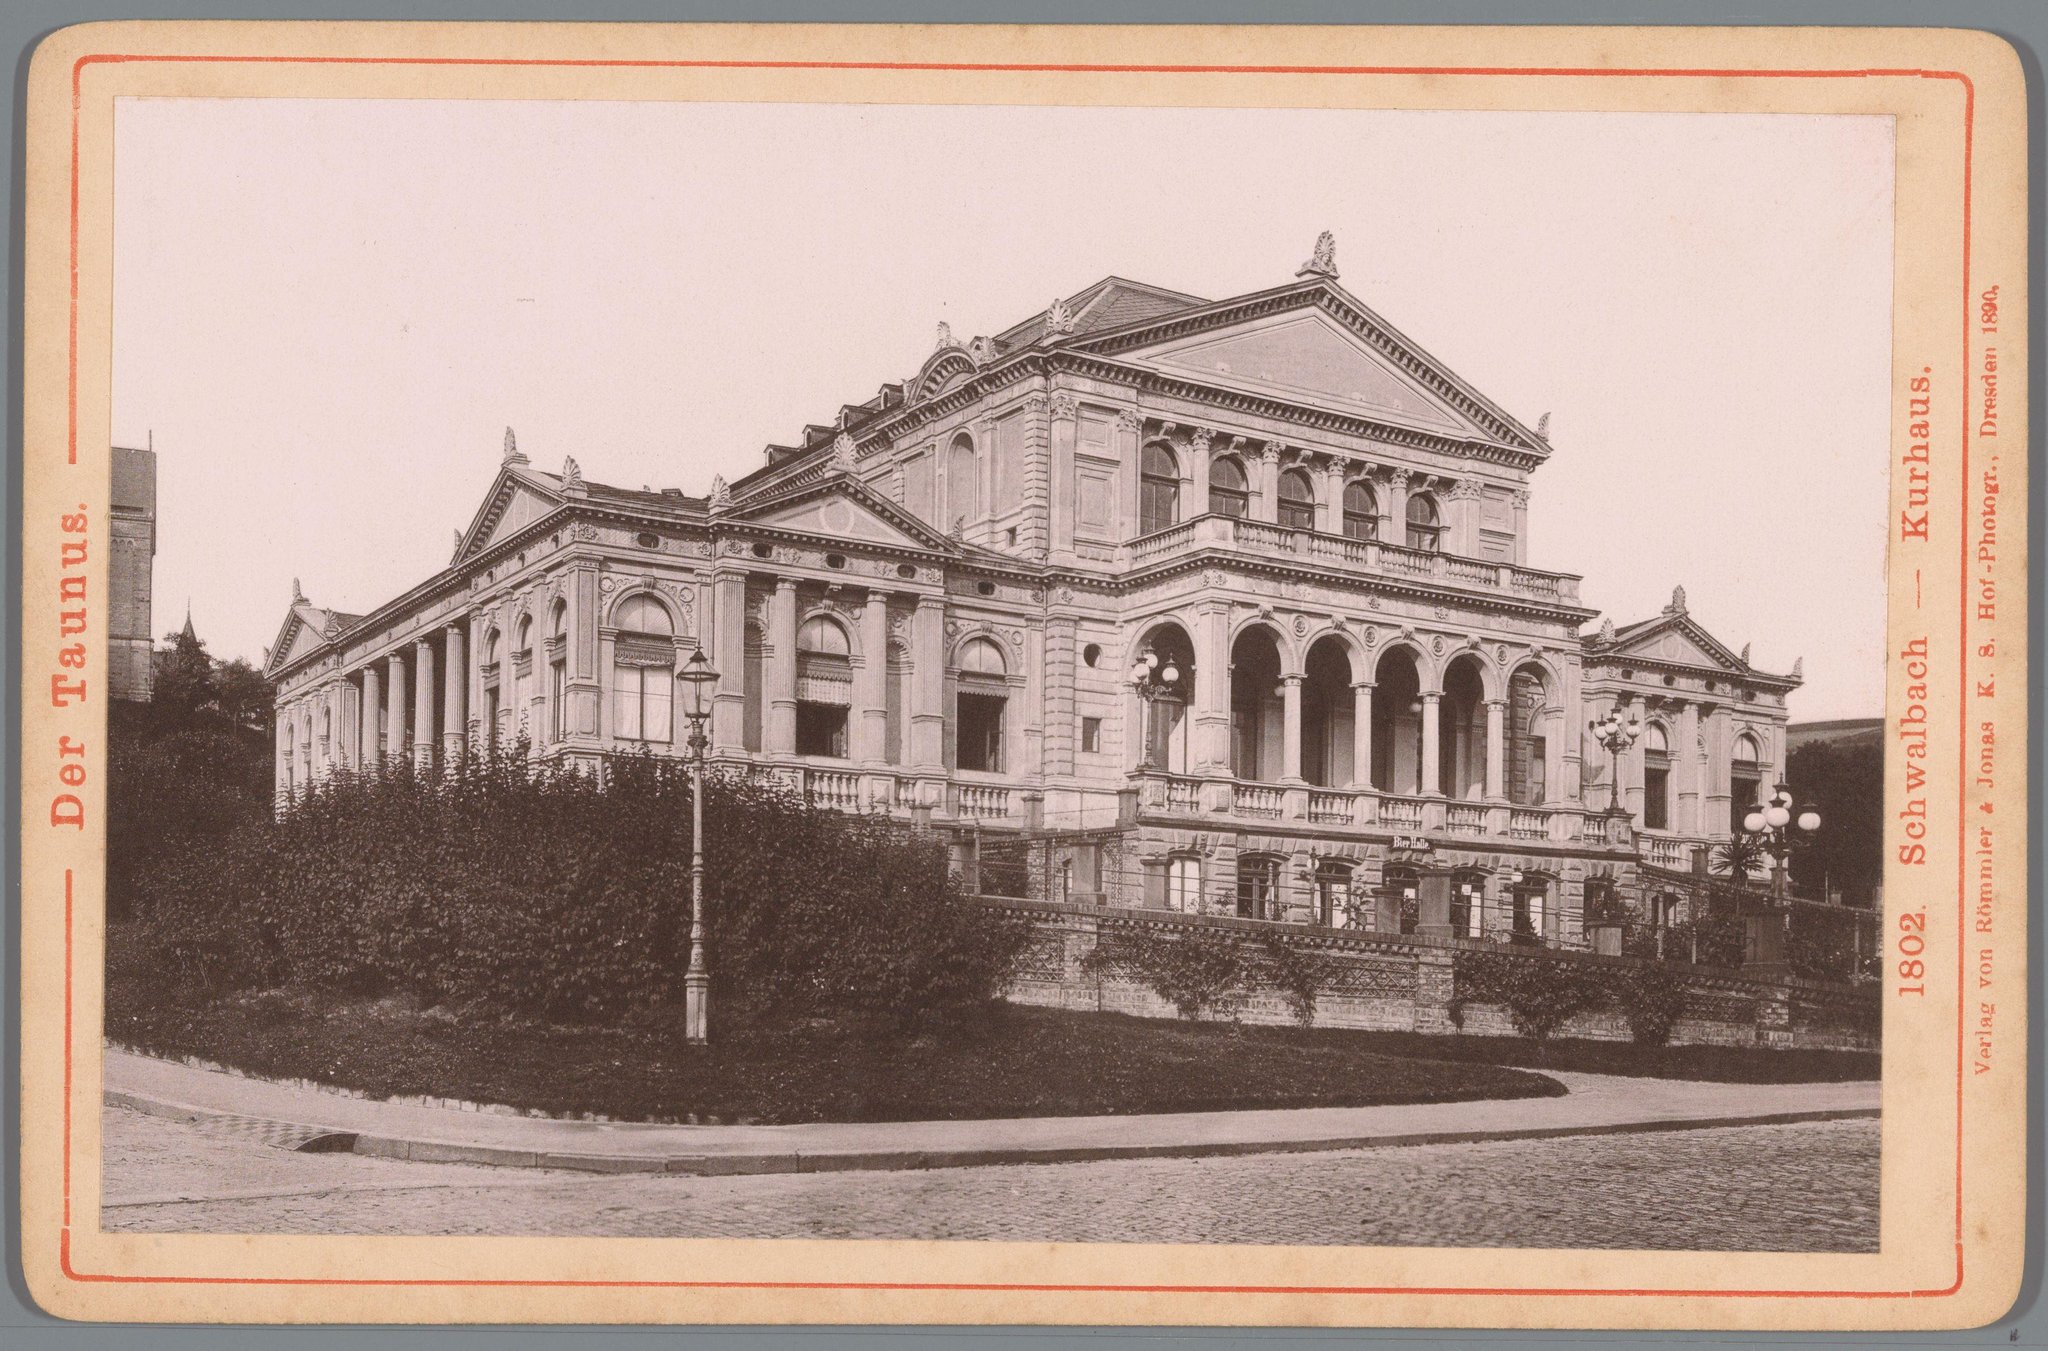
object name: cabinet photograph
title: Gezicht op een kuuroord in Bad Schwalbach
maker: Anonymous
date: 1890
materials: cardboard, paper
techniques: photograph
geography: dresden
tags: watering-place, spa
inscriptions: number: ‘1802.’, name: ‘Ausgabe Römmler & Jonas In gleicher Ausgabe sind einzeln und in Album erschienen: Aachen Arth-Rigibahn (...)’, name: ‘Vosmaer’